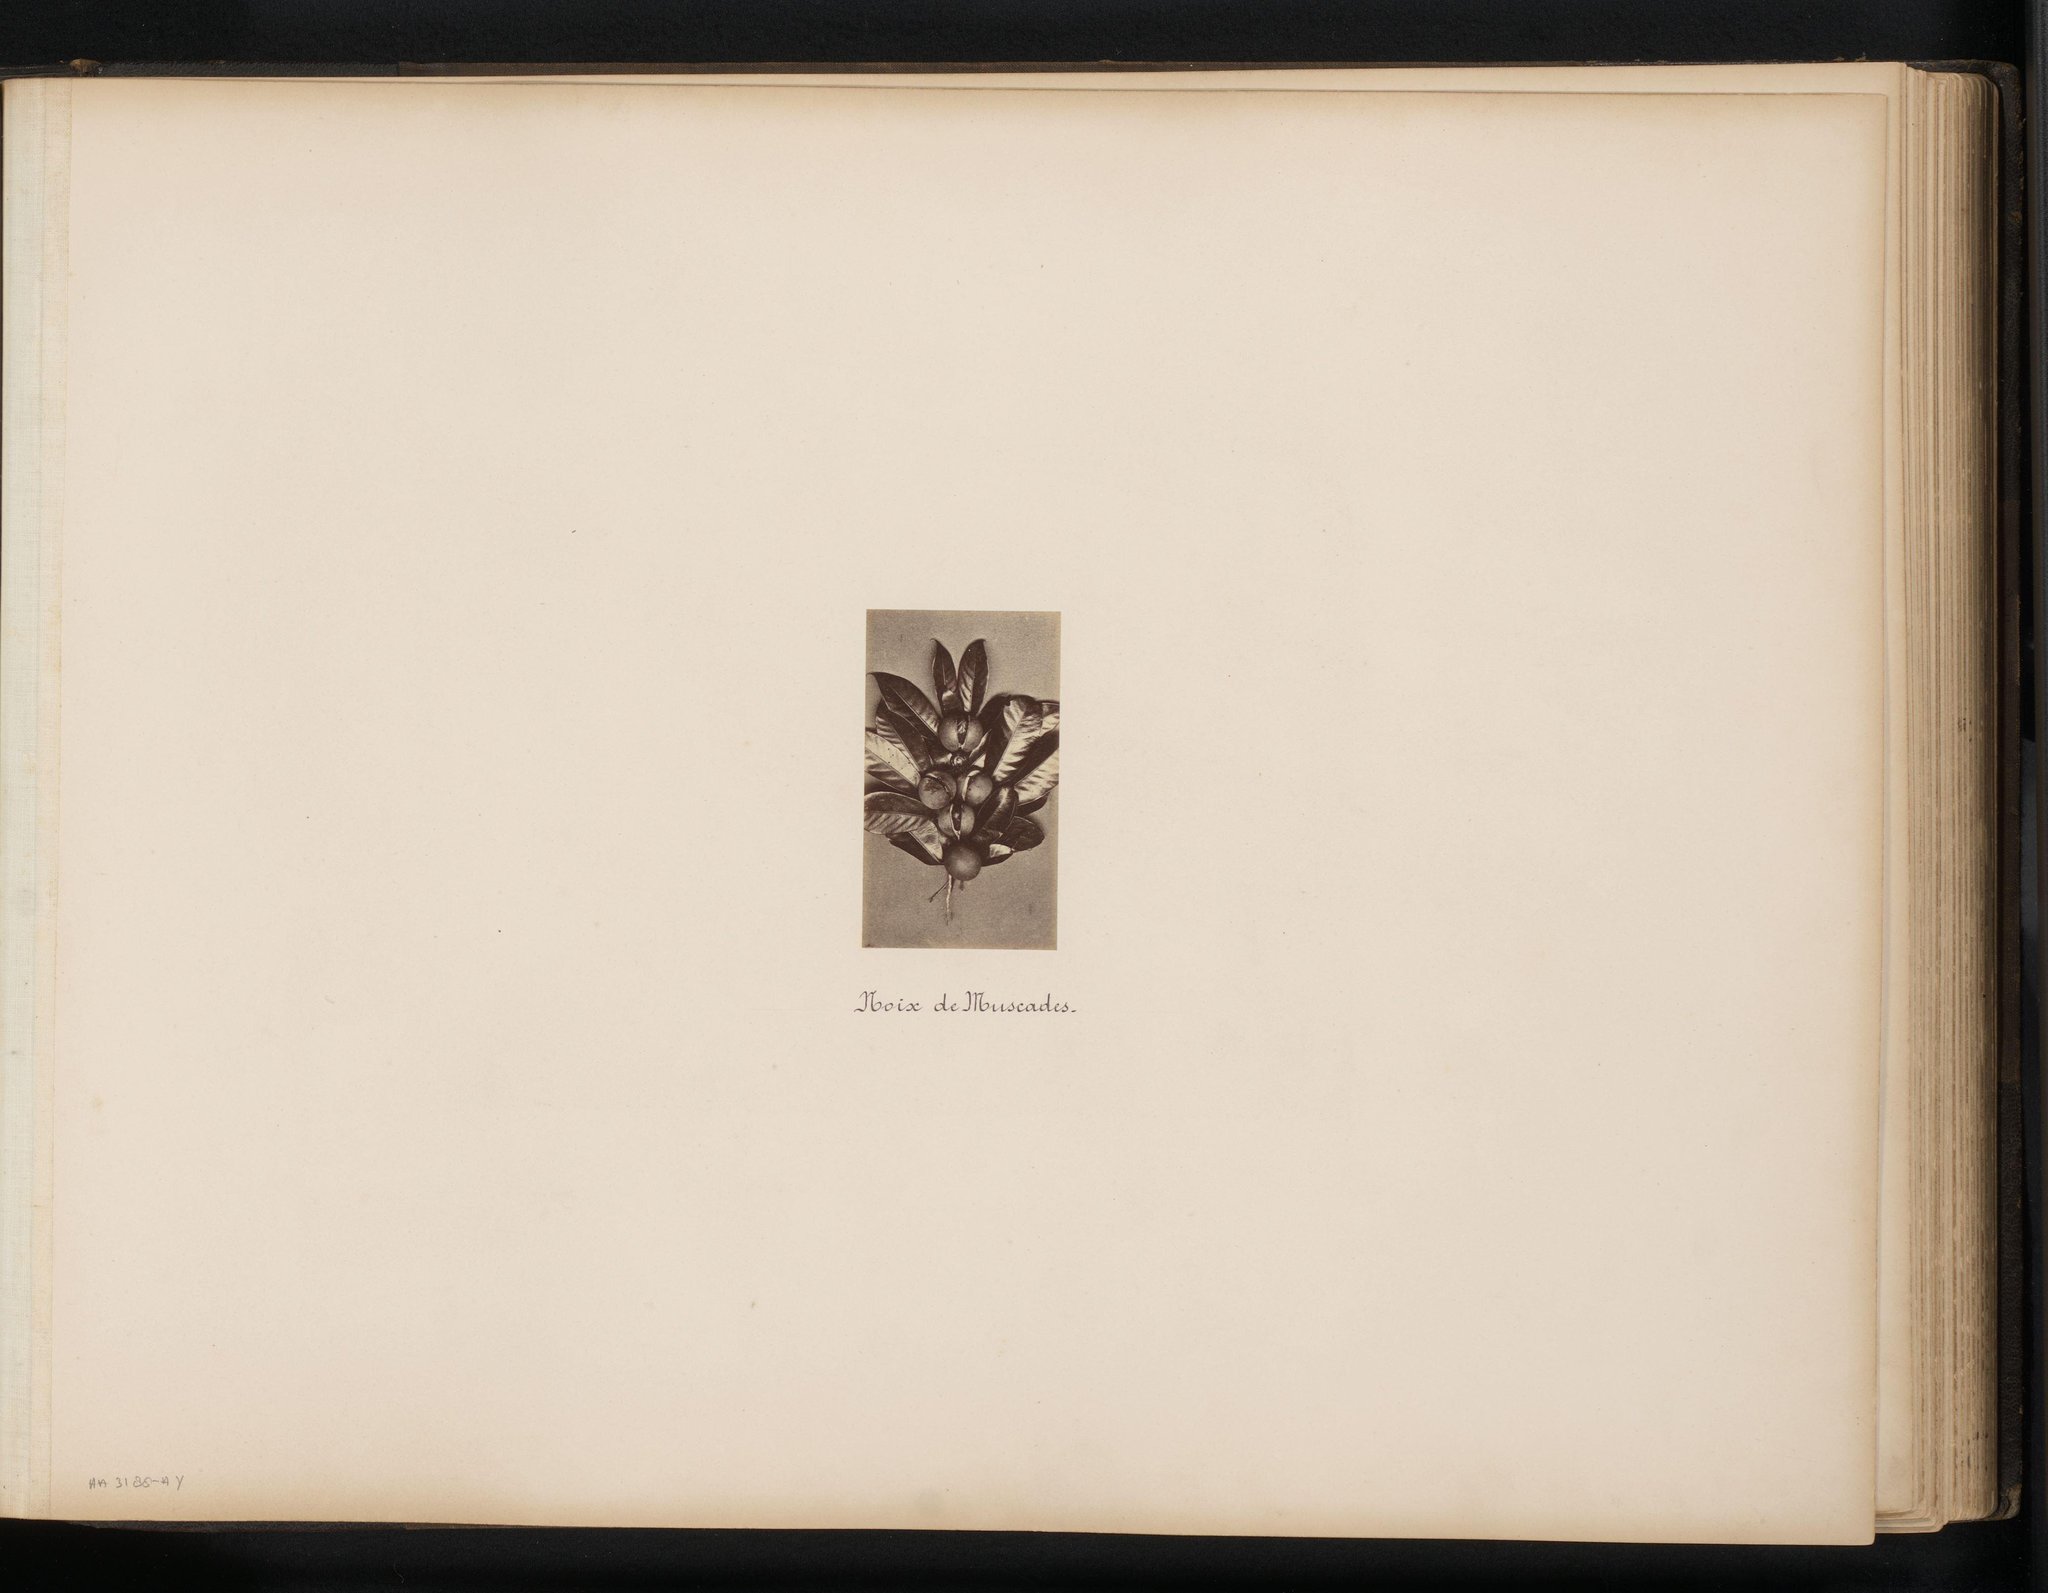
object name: photograph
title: Nootmuskaatplant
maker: Anonymous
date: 1880-1883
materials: photographic support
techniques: albumen print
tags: seasonings, spices (with name)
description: Onderdeel van Reisalbum met opnames van bezienswaardigheden in Egypte, Nederlands-Indië, Singapore en Ceylon.